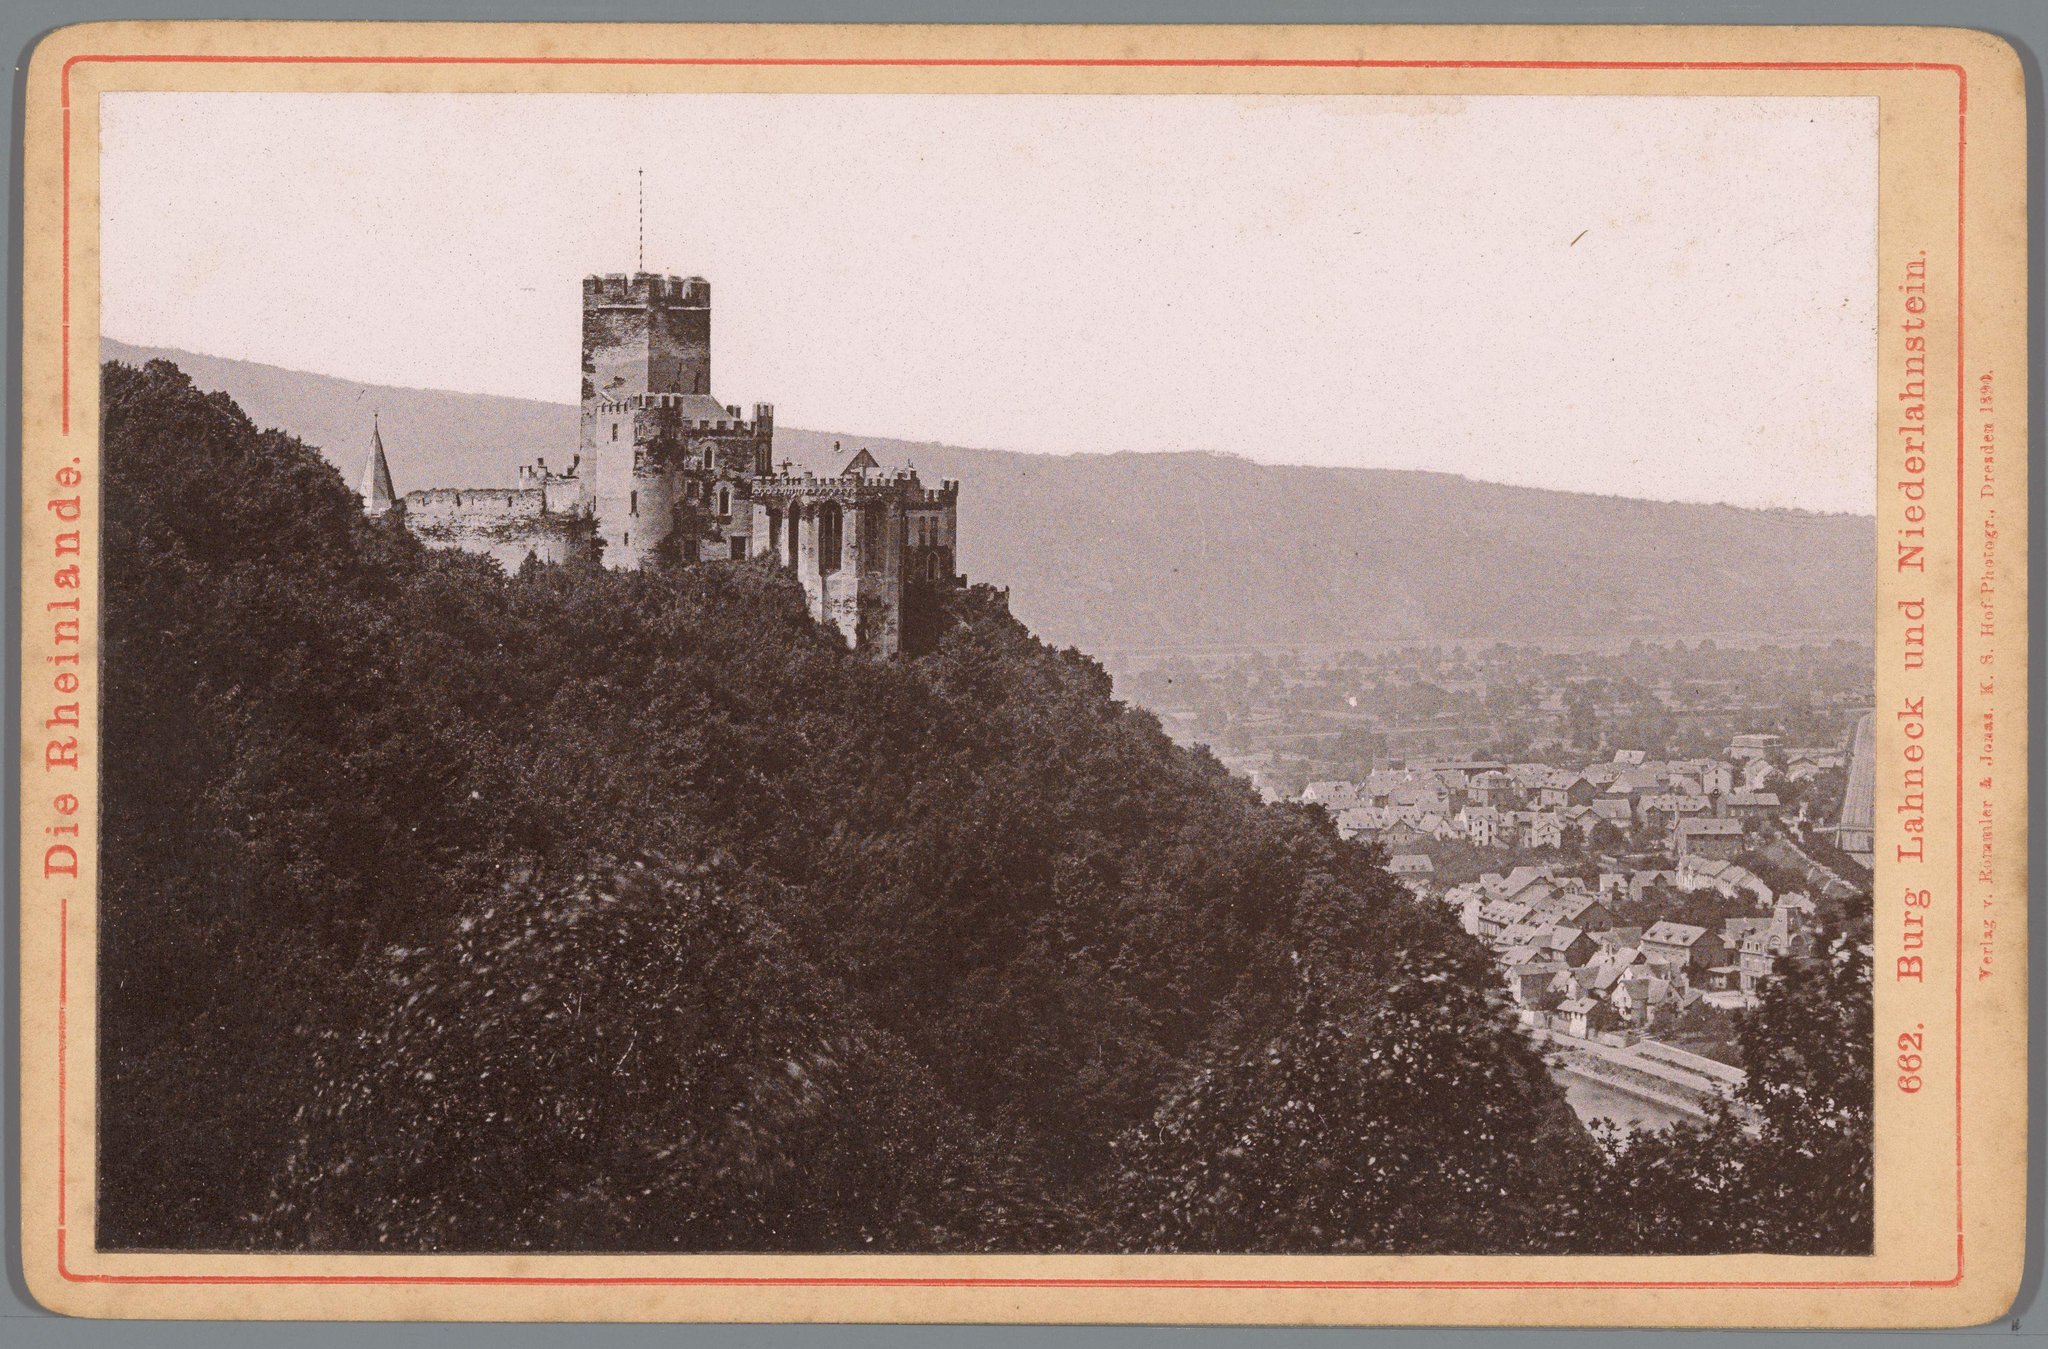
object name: cabinet photograph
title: Gezicht op Burg Lahneck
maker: Anonymous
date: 1890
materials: cardboard, paper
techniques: photograph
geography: dresden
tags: castle, mountains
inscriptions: name: ‘Vosmaer’, number: ‘662.’